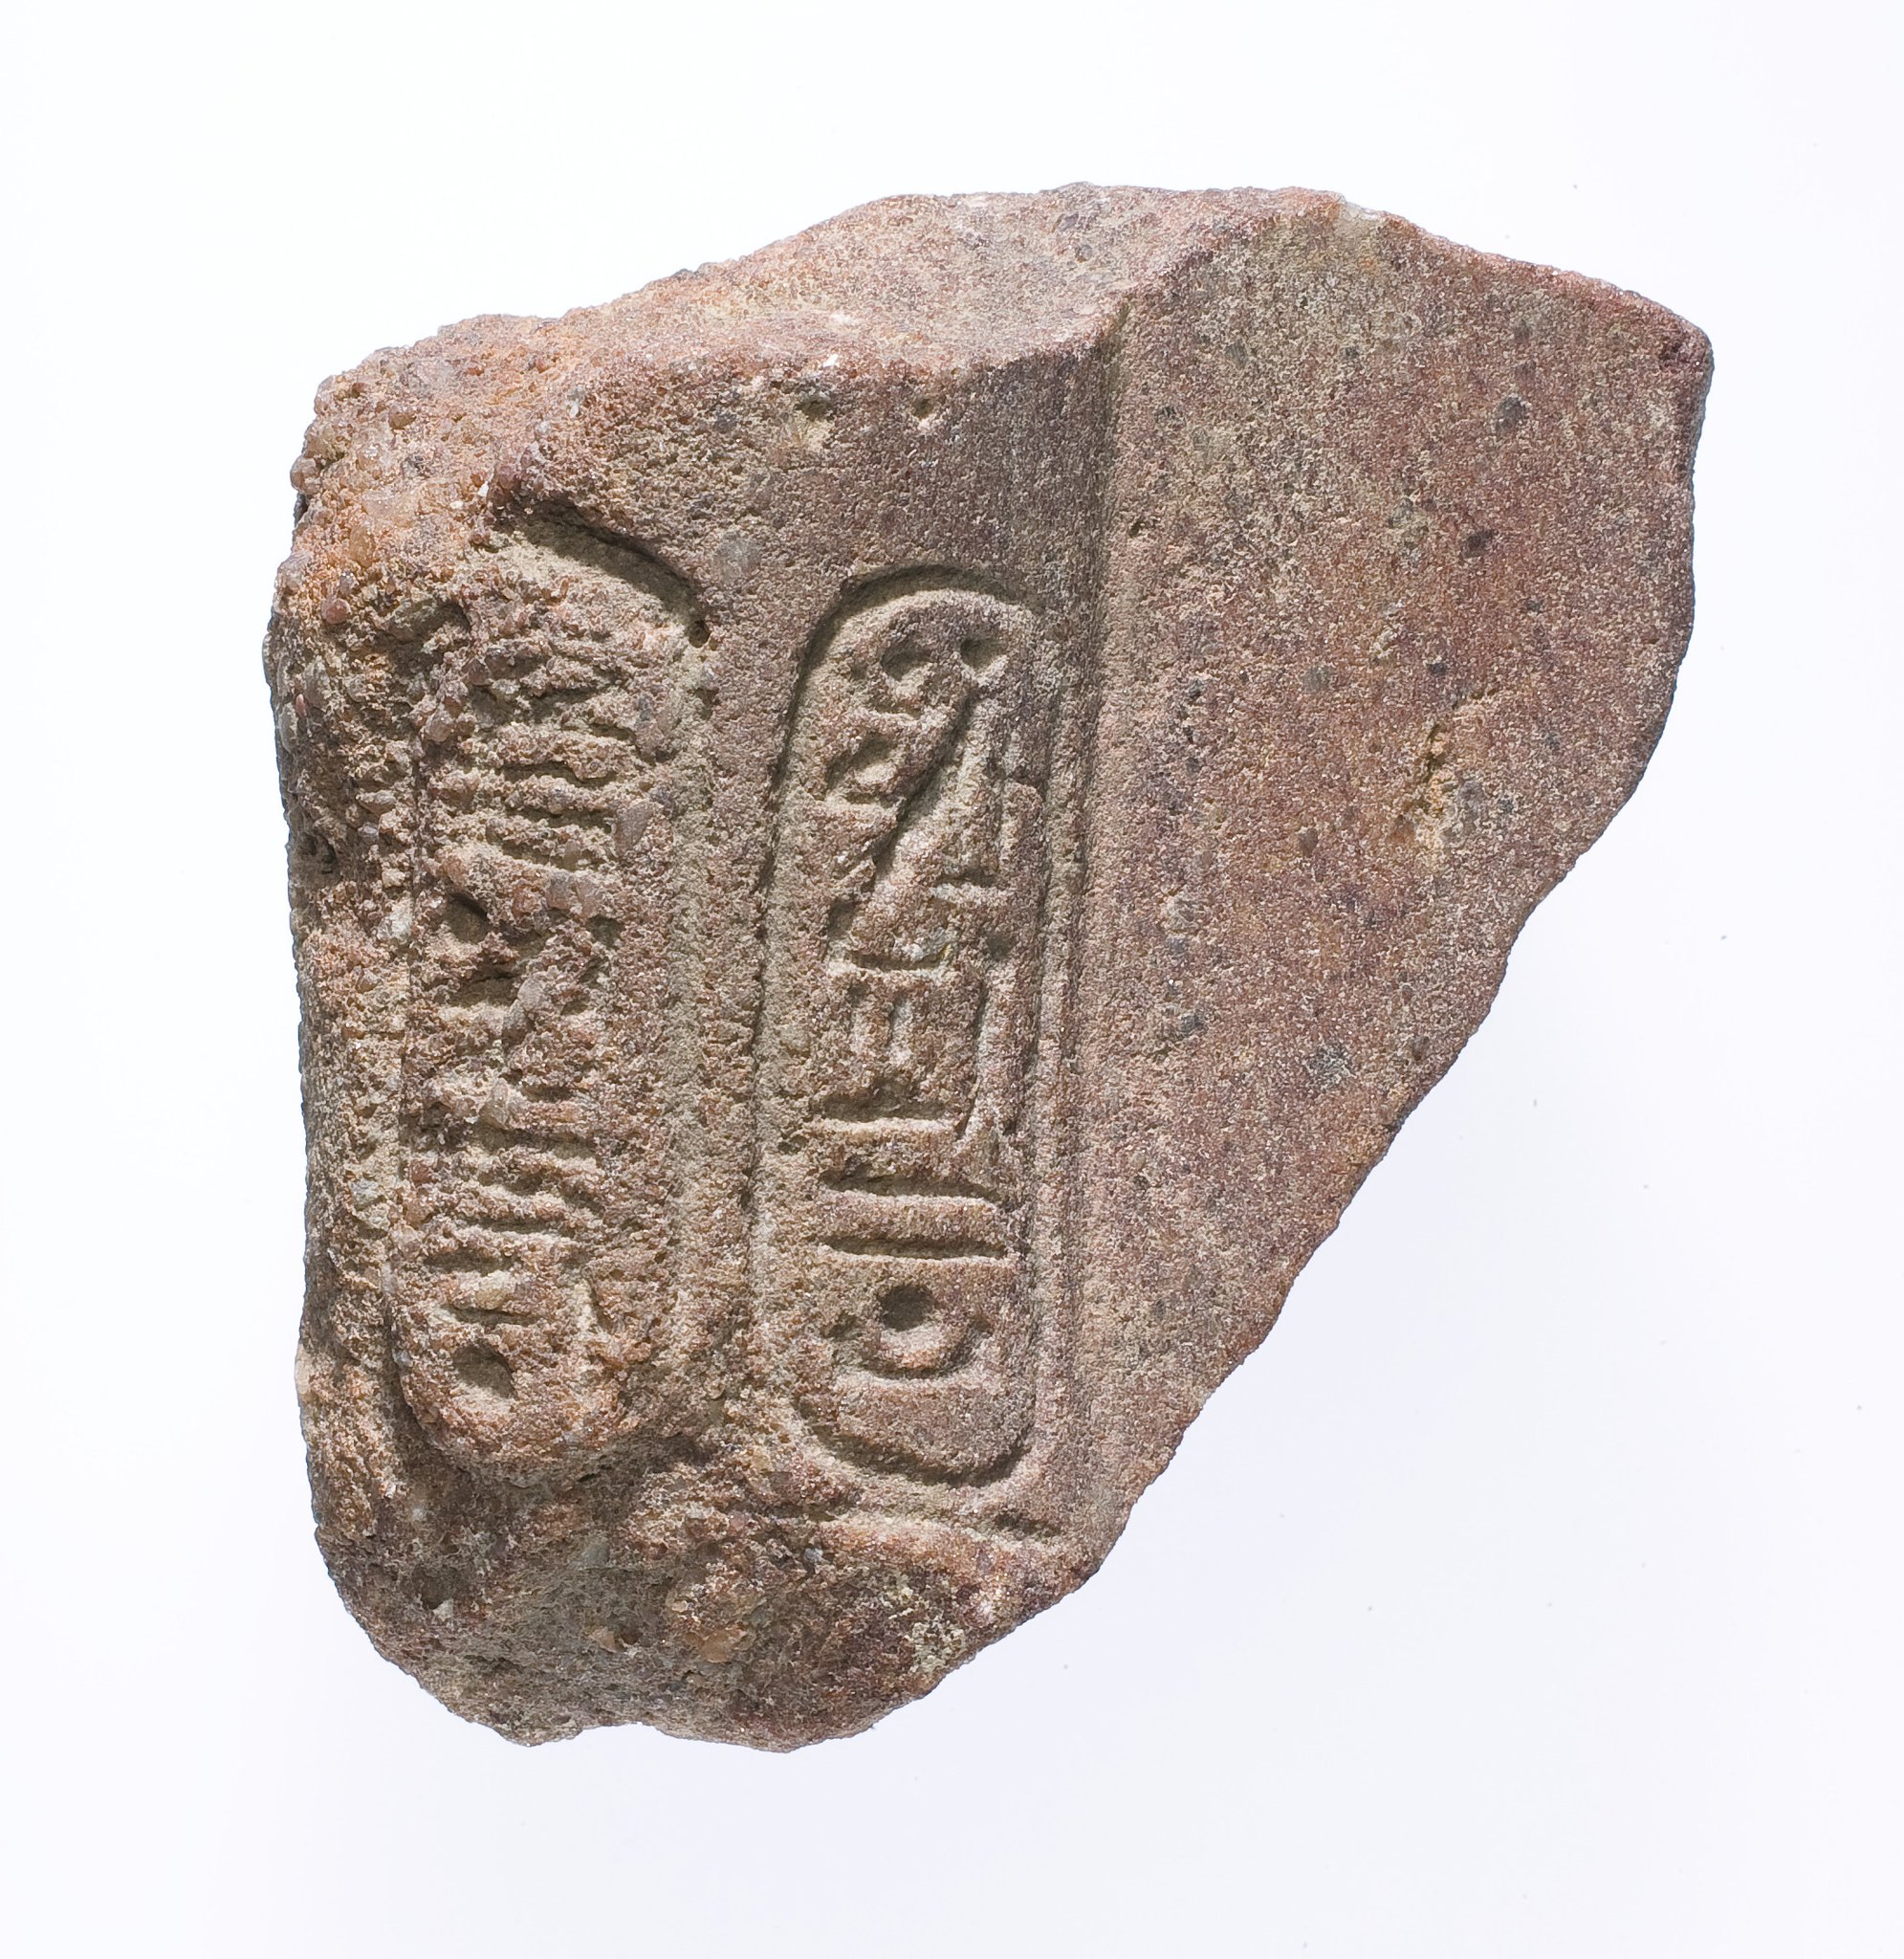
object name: upper right arm, aten cartouch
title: right arm with Aten cartouches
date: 1353-1336 BCE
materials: quartzite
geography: egypt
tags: hieroglyphs